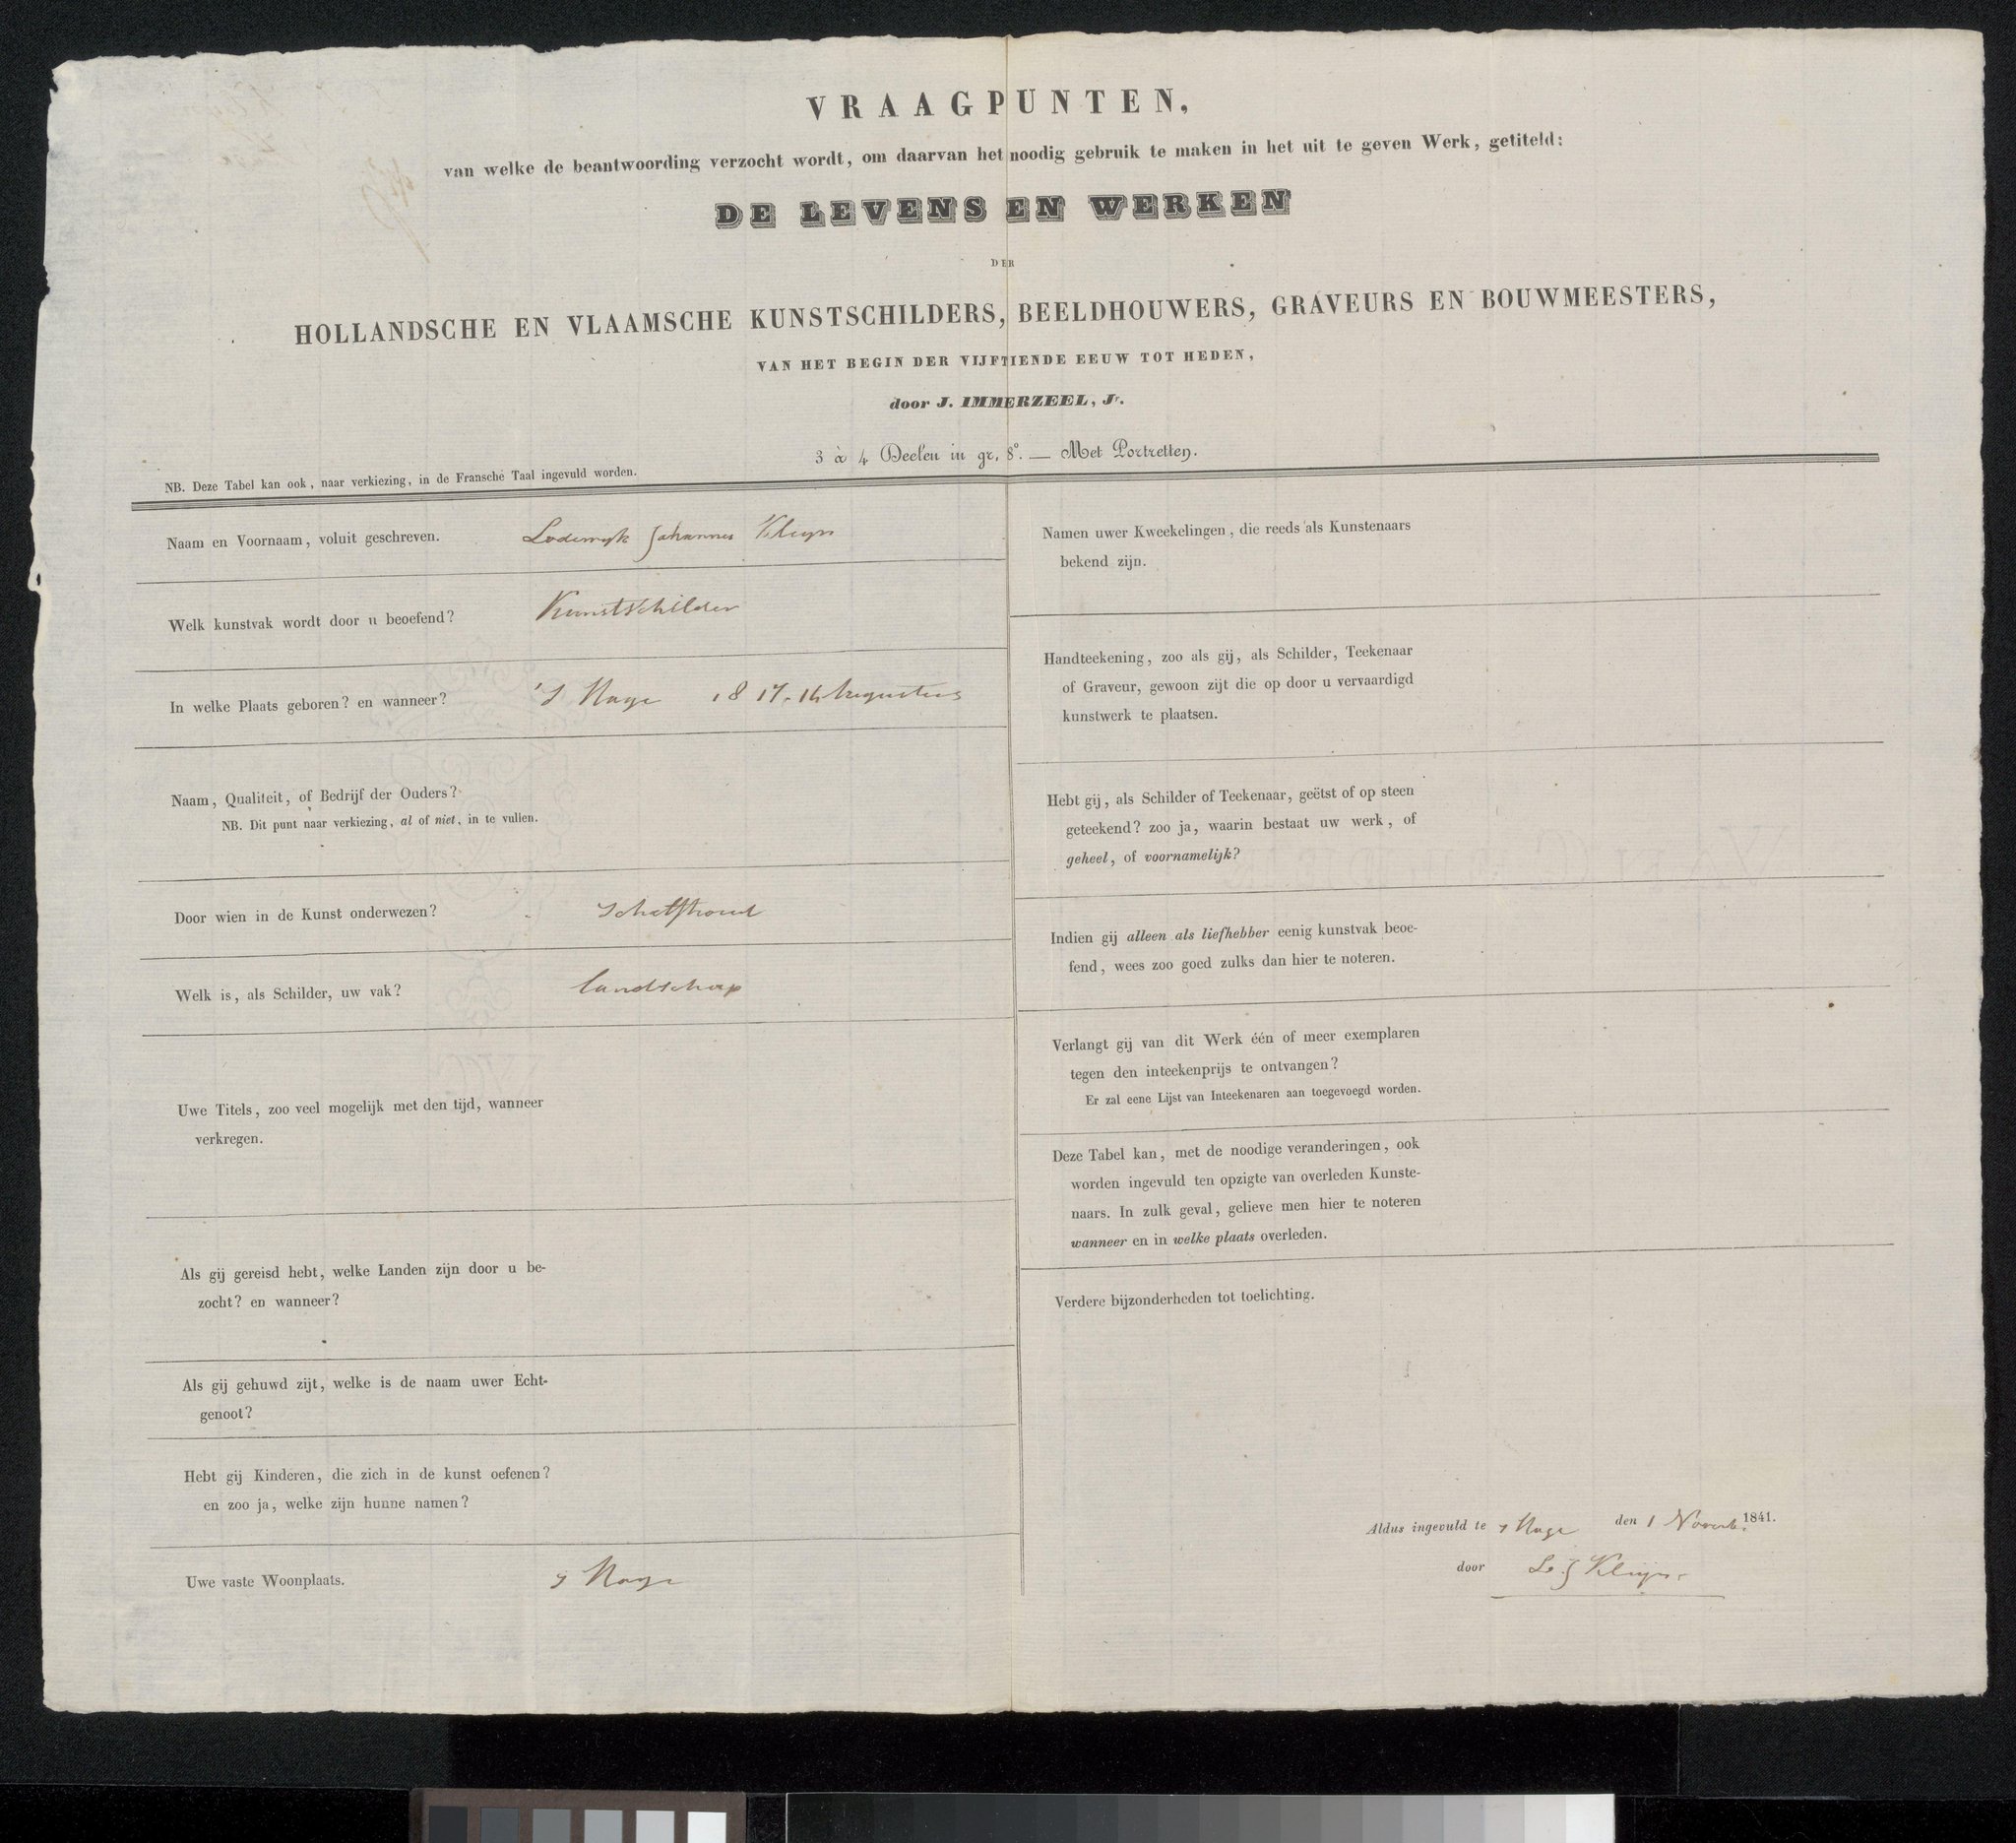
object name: manuscript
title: Enquêteformulier ingevuld door Lodewijk Johannes Kleijn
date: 1841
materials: ink, paper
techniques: pen, printing, writing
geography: the hague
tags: print maker, draughtsman, lodewijk johannes kleijn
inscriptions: watermark, inscription: ‘Vraagpunten,/ van welke de beantwoording verzocht wordt, om daarvan het noodig gebruik te maken in het uit te geven Werk, getiteld: De levens en werken/ der Hollandsche en Vlaamsche kunstschilders, beeldhouwers,/ graveurs en bouwmeesters, van het begin der vijftiende eeuw tot heden/ door J. Immerzeel, Jr.’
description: Opgenomen in: Immerzeel, J. Jr., De levens en werken der Hollandsche en Vlaamsche kunstschilders, beeldhouwers, graveurs en bouwmeesters, van het begin der vijftiende eeuw tot heden, Amsterdam: J.C. van Kesteren, 1842-1843.